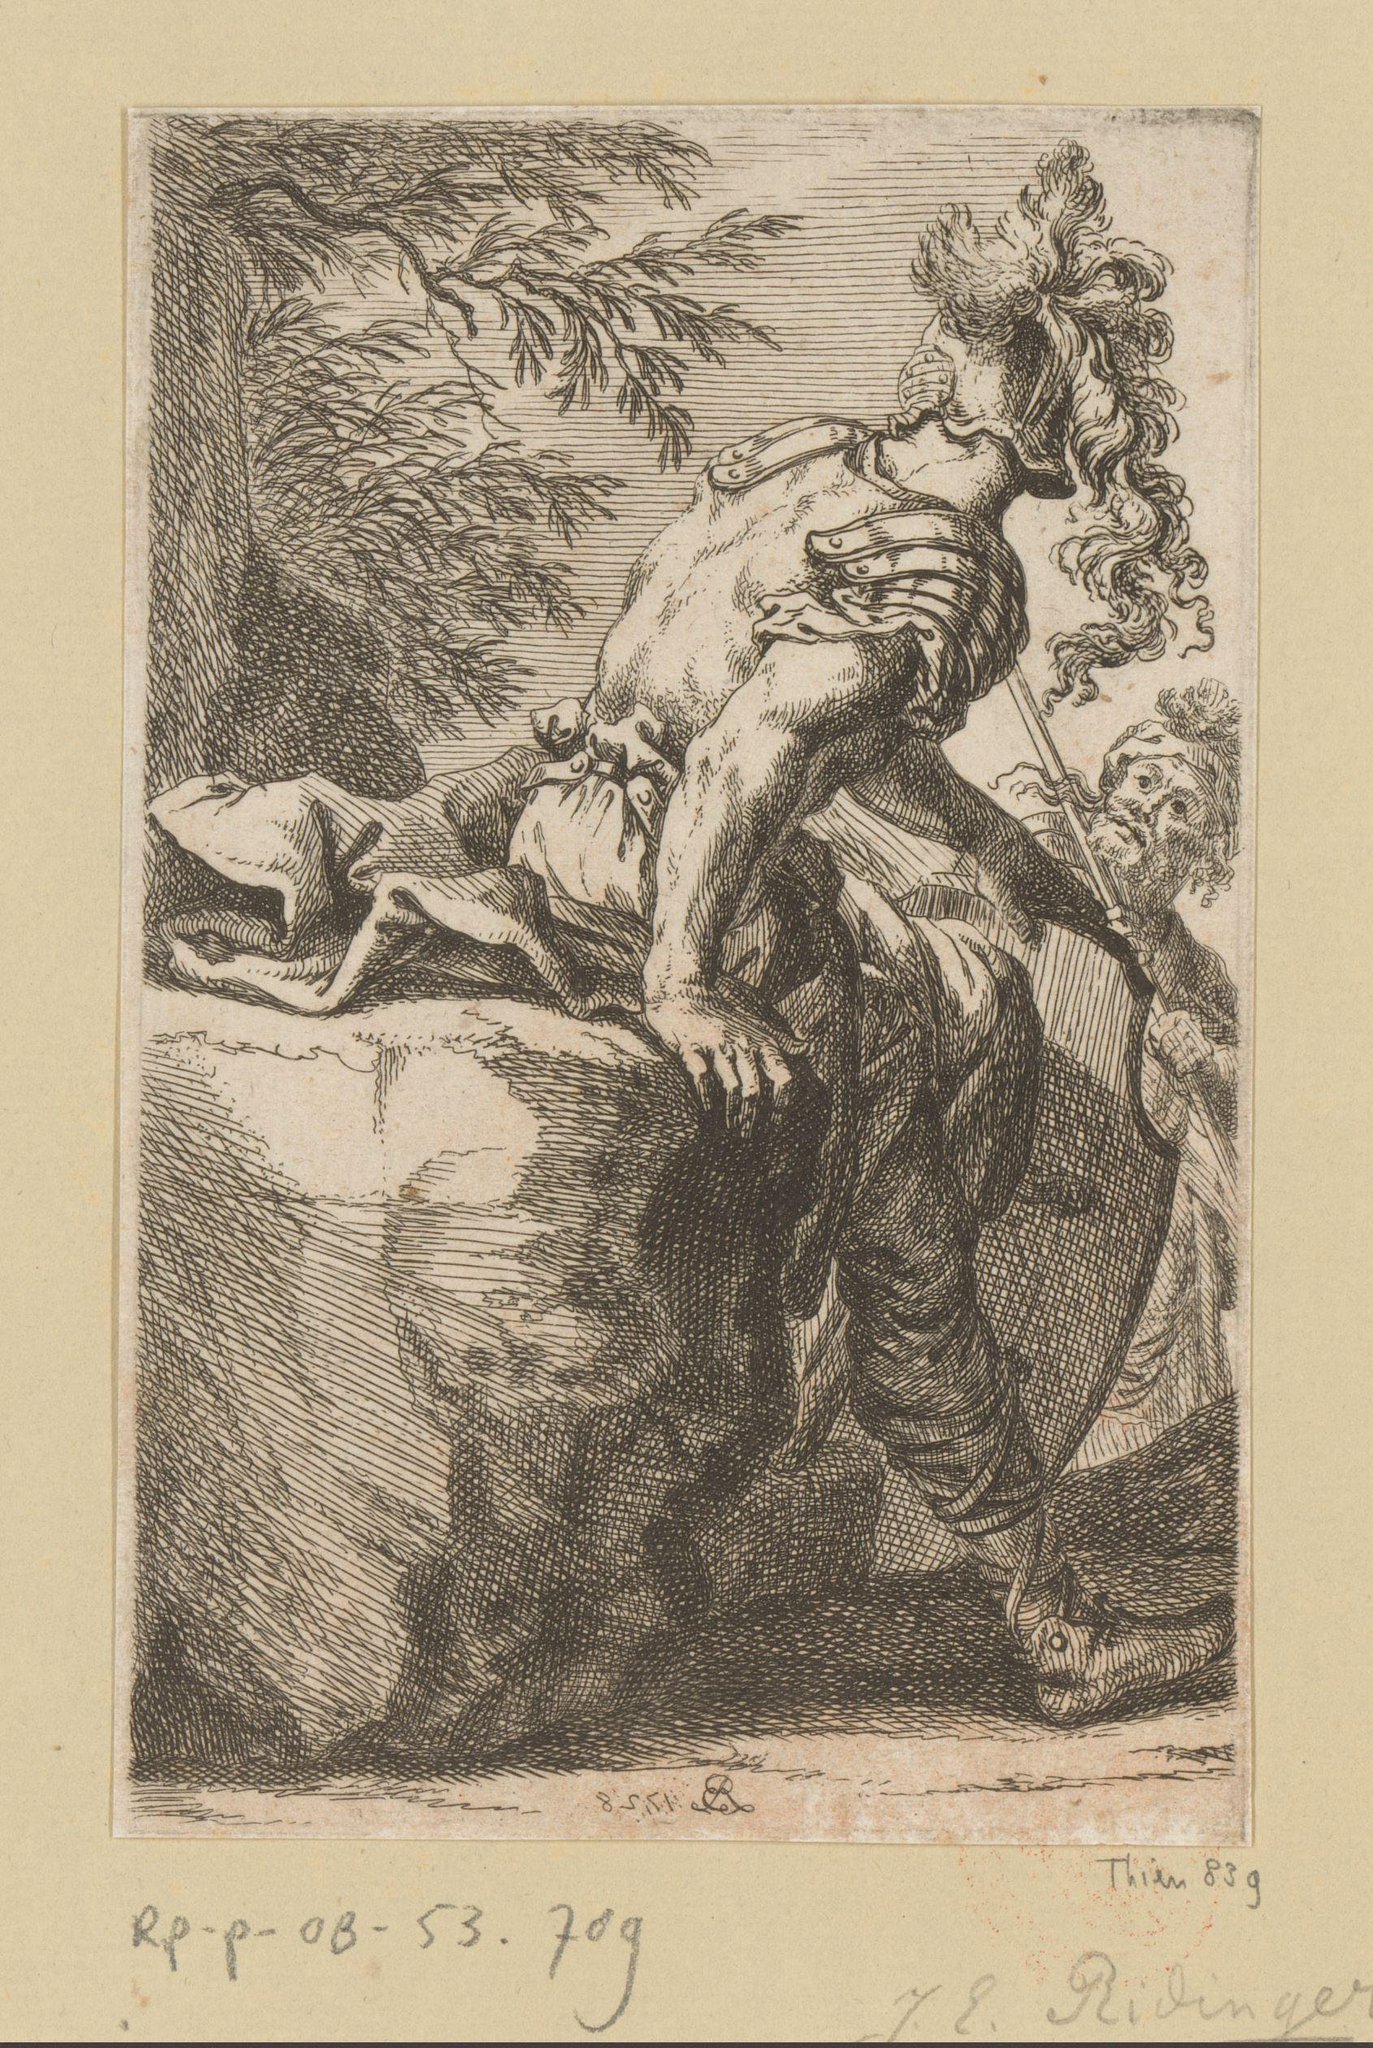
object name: print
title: Soldaten uit de klassieke oudheid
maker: johann elias ridinger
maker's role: draughtsman, painter, print maker, publisher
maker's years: 1698-1767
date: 1728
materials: paper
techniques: etching, intaglio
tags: the soldier; the soldier's life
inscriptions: collector's mark: Lugt 240